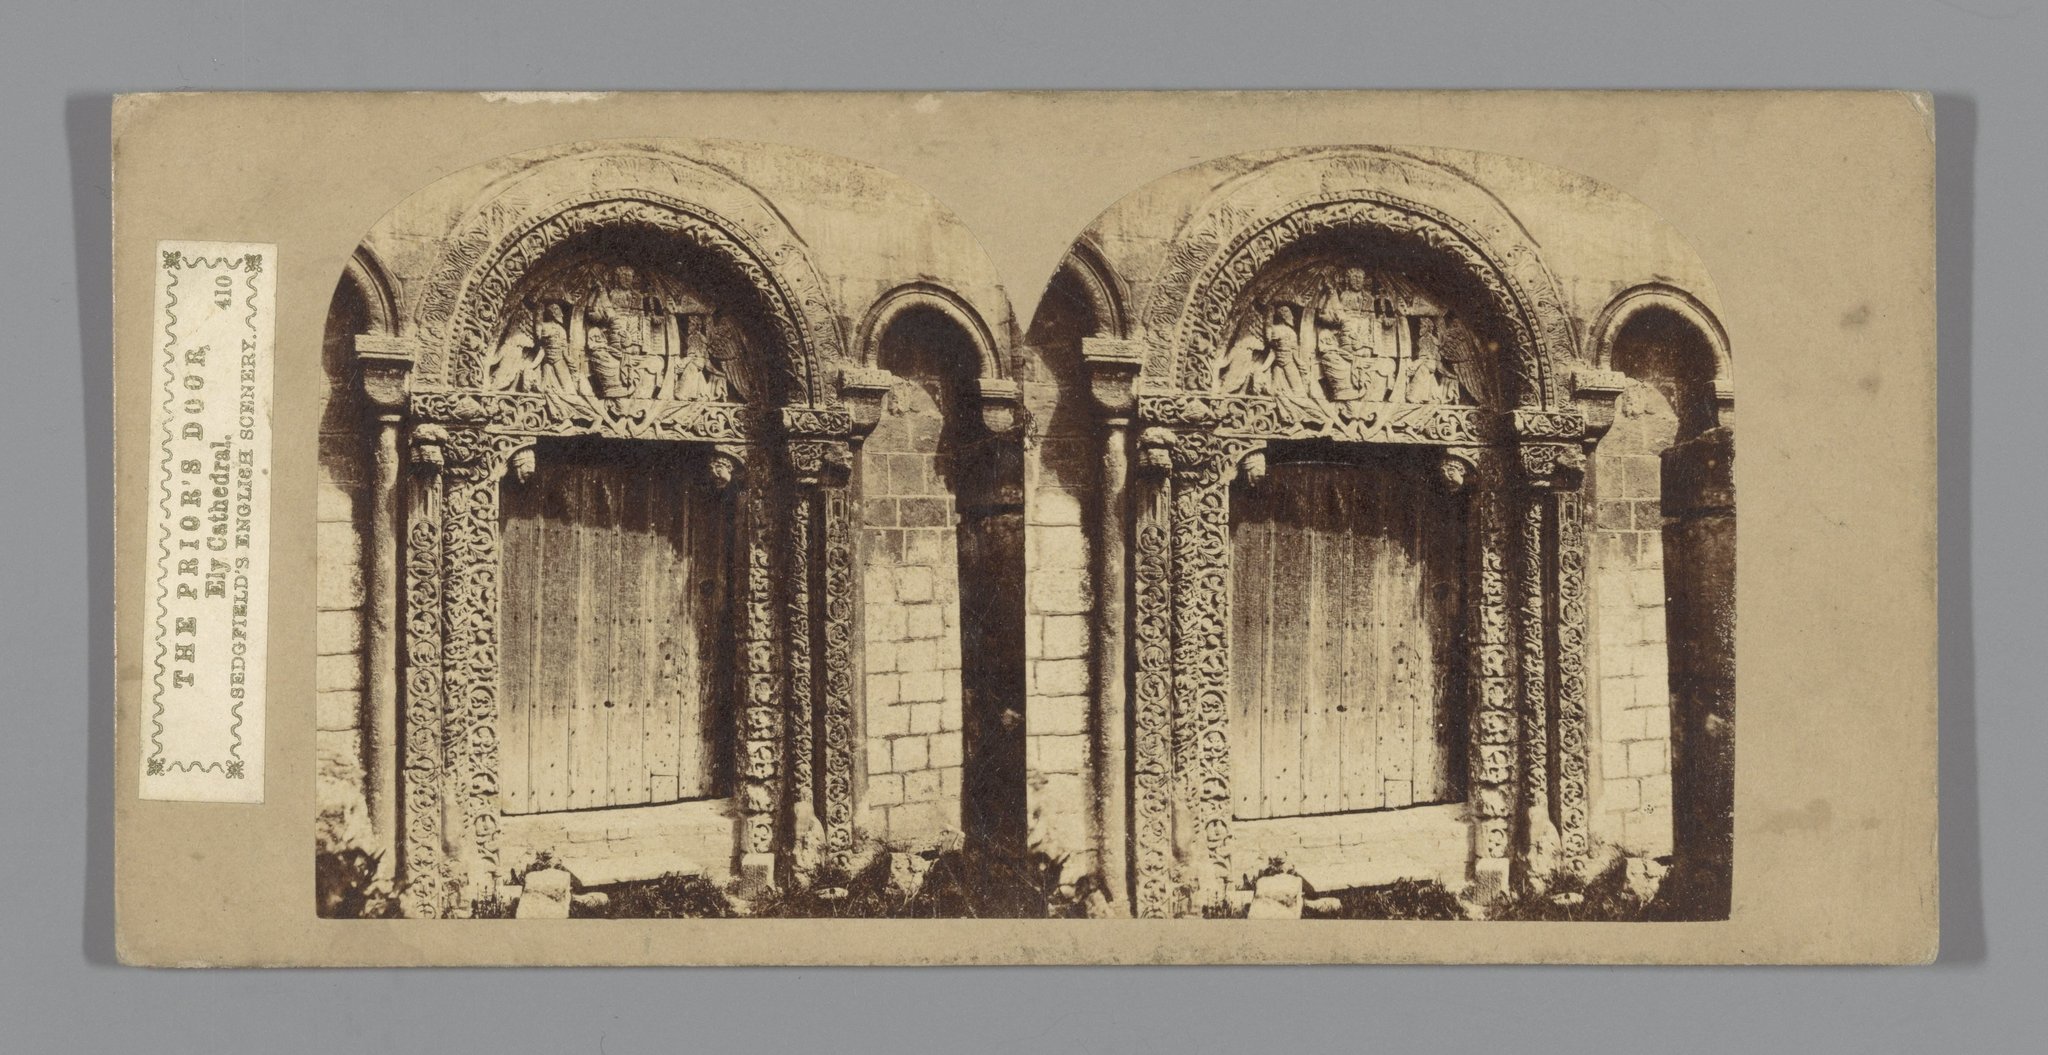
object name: stereograph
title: The Prior's Door, Ely's Cathedral.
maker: william russell sedgfield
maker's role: fotograaf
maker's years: 1826-1902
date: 1850-1880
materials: cardboard, photographic support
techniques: albumen print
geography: ely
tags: parts of church exterior and annexes: portal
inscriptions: inscription: ‘Sedgfield's English Scenery.’, number: ‘410’